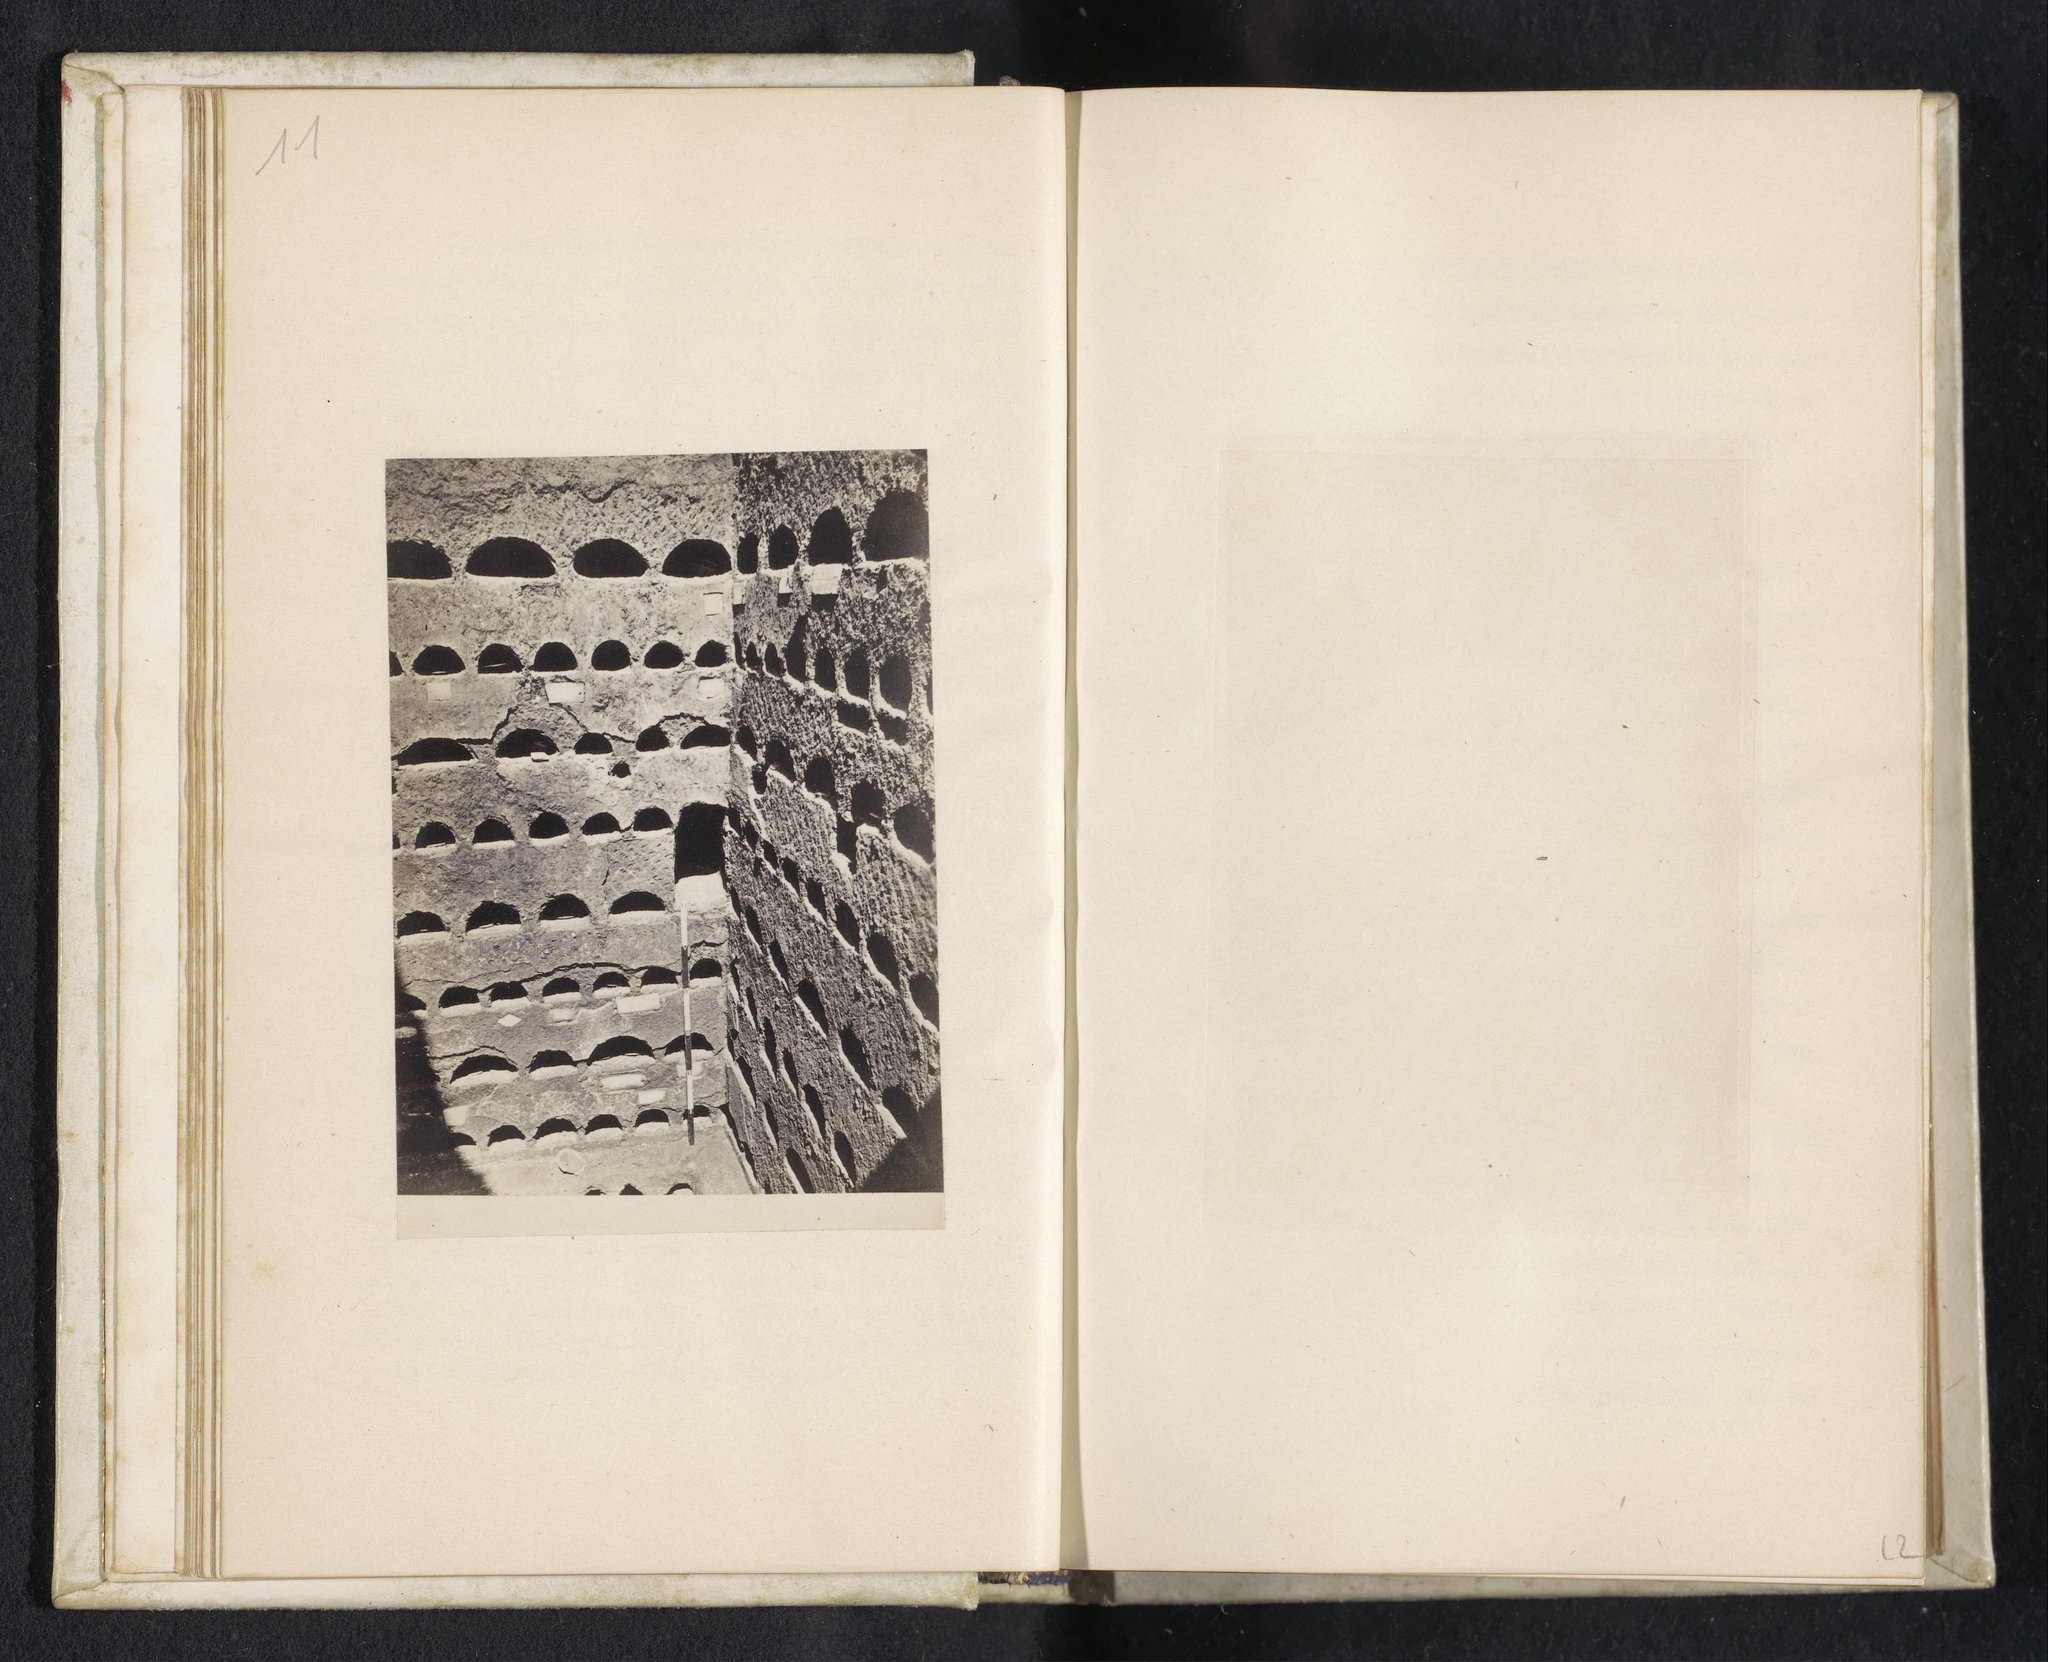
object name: photograph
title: Nissen in de catacomben van Rome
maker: Anonymous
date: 1850-1860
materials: photographic support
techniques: albumen print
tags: catacombs, rome